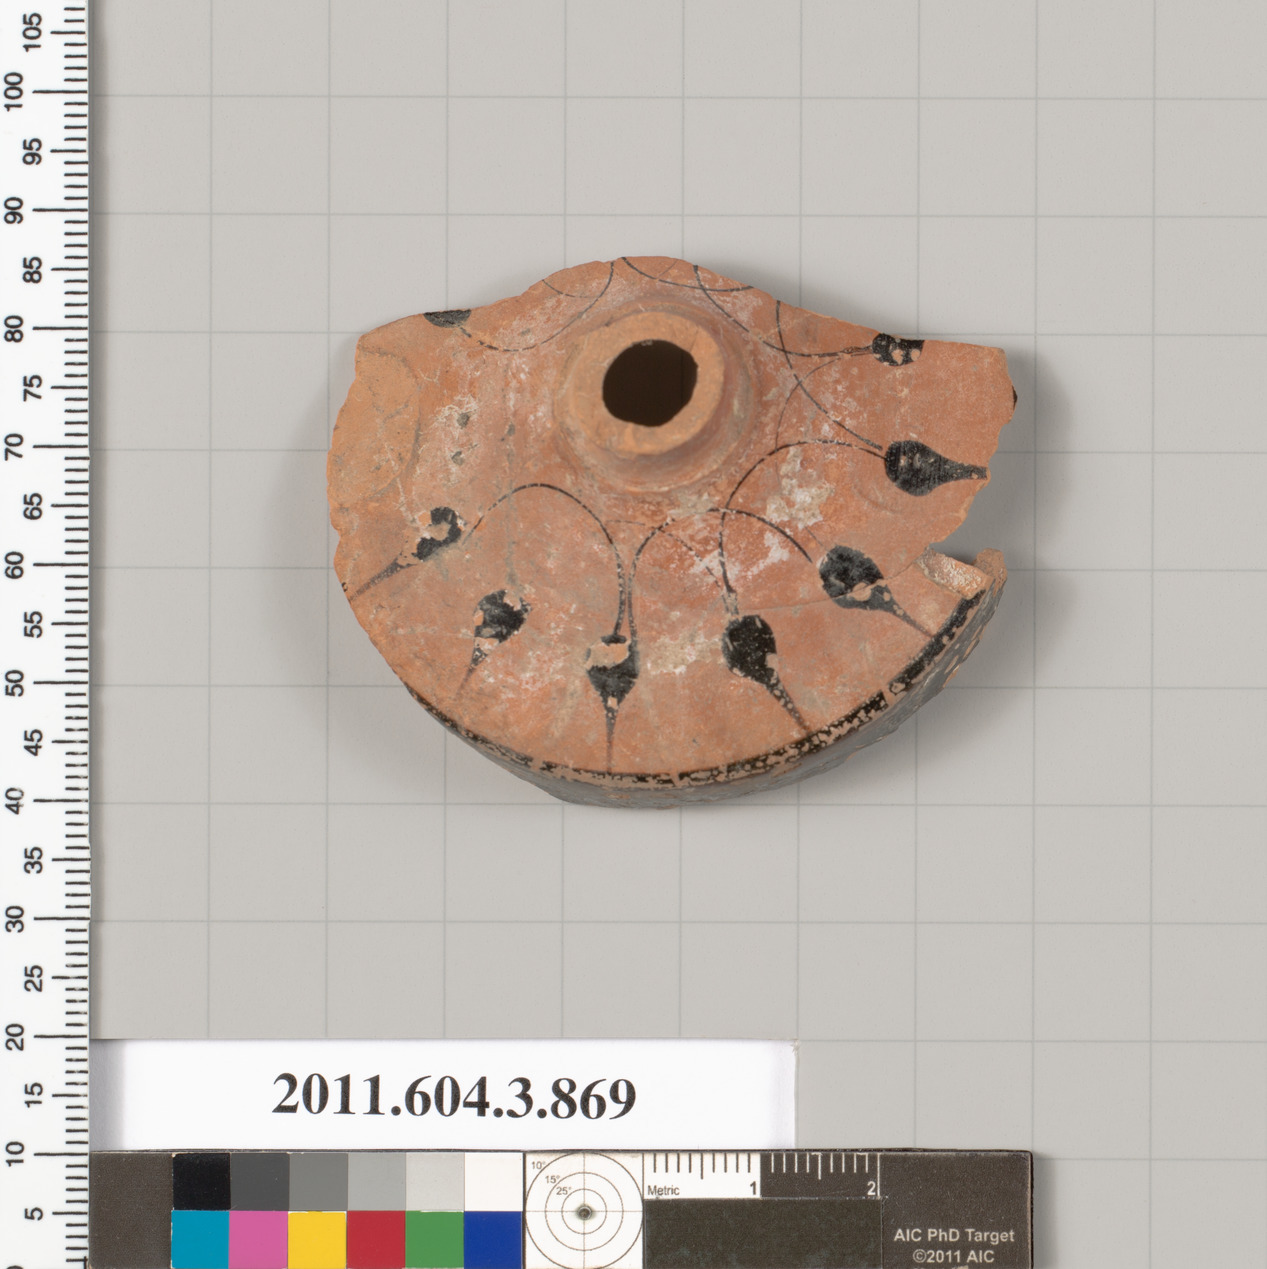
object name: lekythos fragment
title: Terracotta fragment of a lekythos (oil flask)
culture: greek, attic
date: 500-468 BCE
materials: terracotta